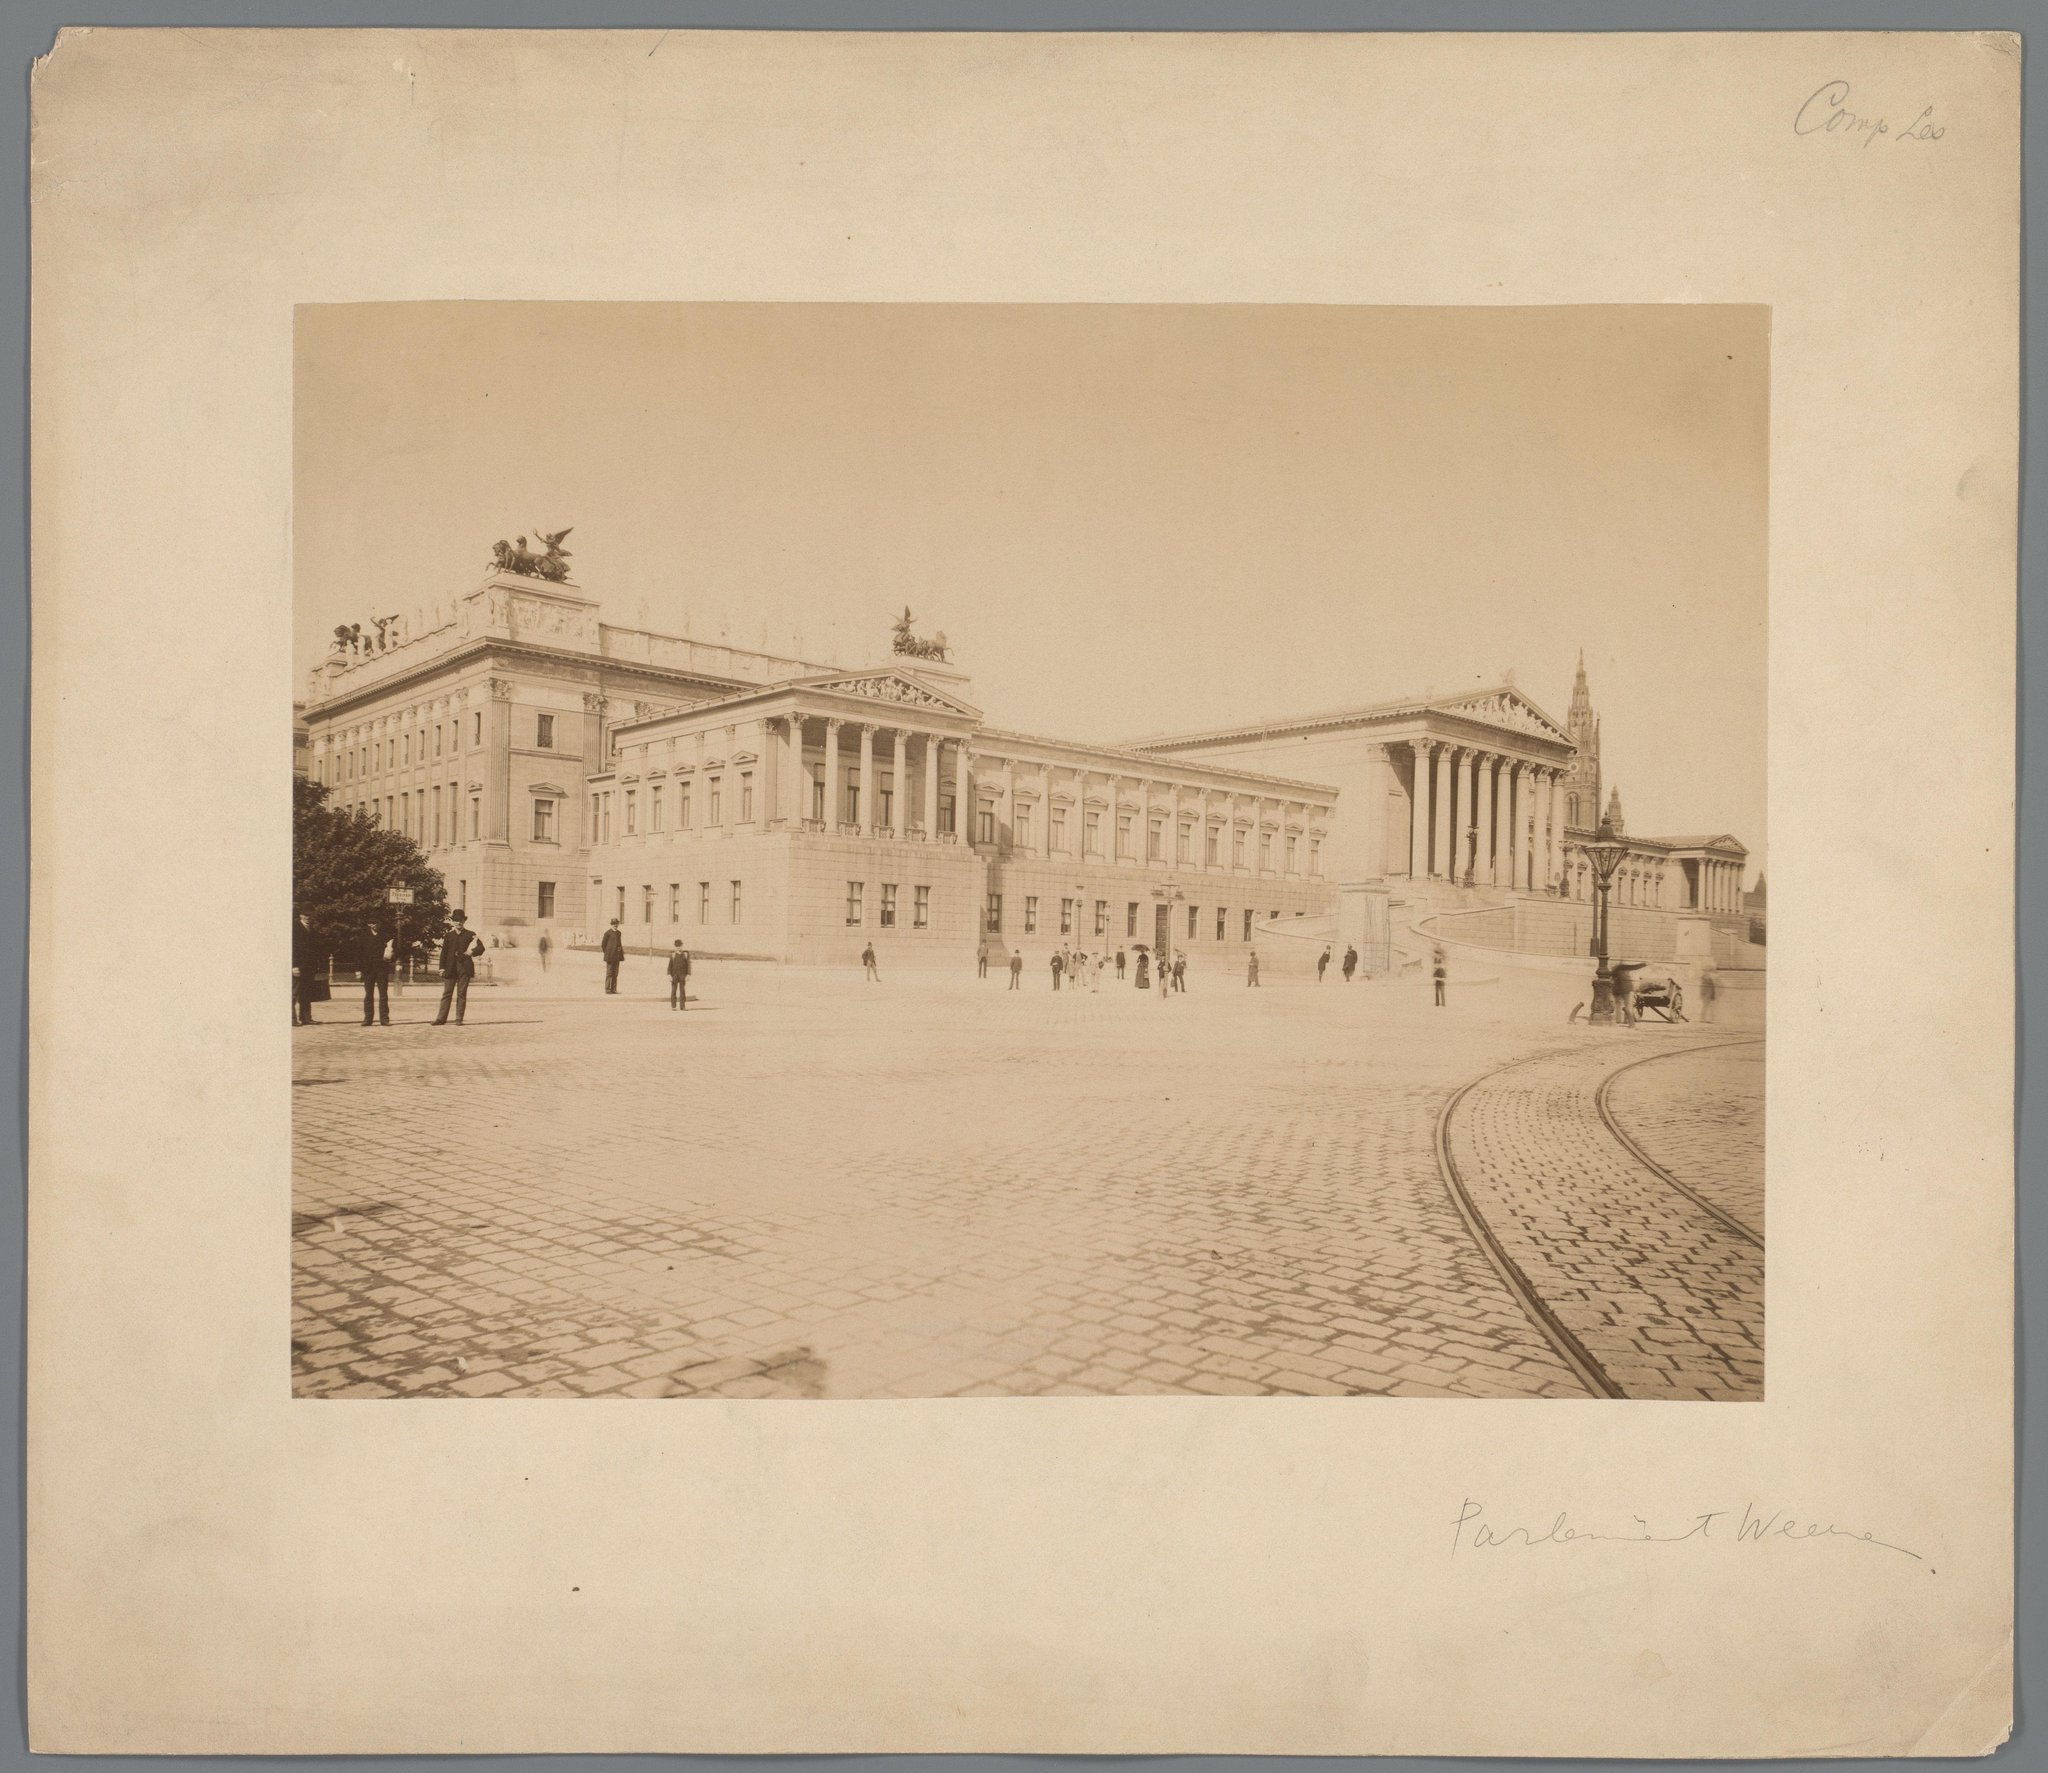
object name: photograph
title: Gezicht op het Oostenrijkse parlement, Wenen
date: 1884-1894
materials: cardboard, paper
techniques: albumen print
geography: the hague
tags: lower house, parliament, chamber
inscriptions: collector's mark: Lugt 3937, inscription: ‘Comp Lex’, inscription: ‘Wien. Hoherathsgebäude’, stamp: ‘J.A.G. de Leur/ Représentant/ Huigenspark 40b/ Den Haag’